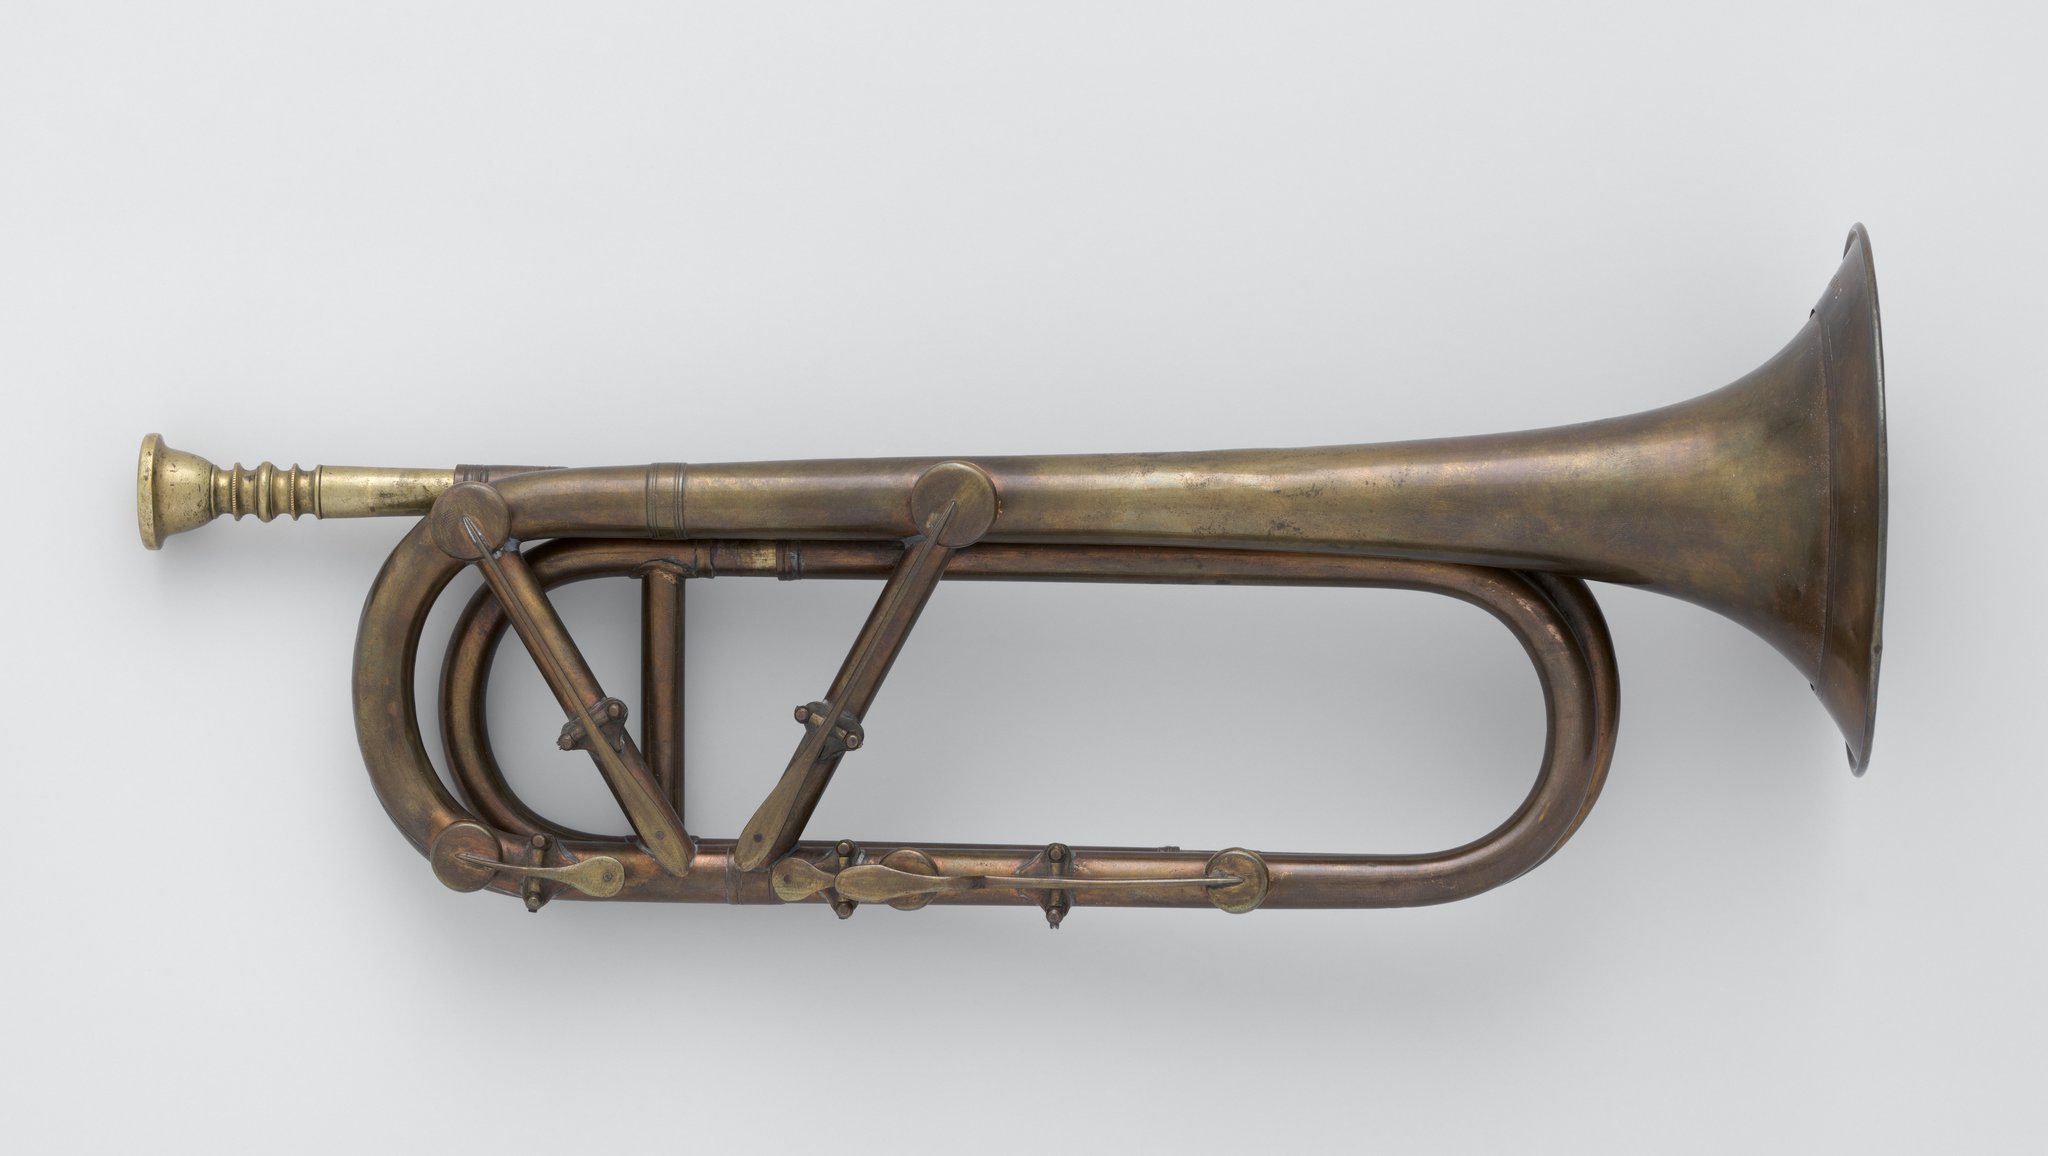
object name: keyed trumpet in g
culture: italian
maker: leonardo massarenti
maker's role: maker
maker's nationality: italian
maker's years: 1838-1843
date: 1840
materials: brass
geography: italy